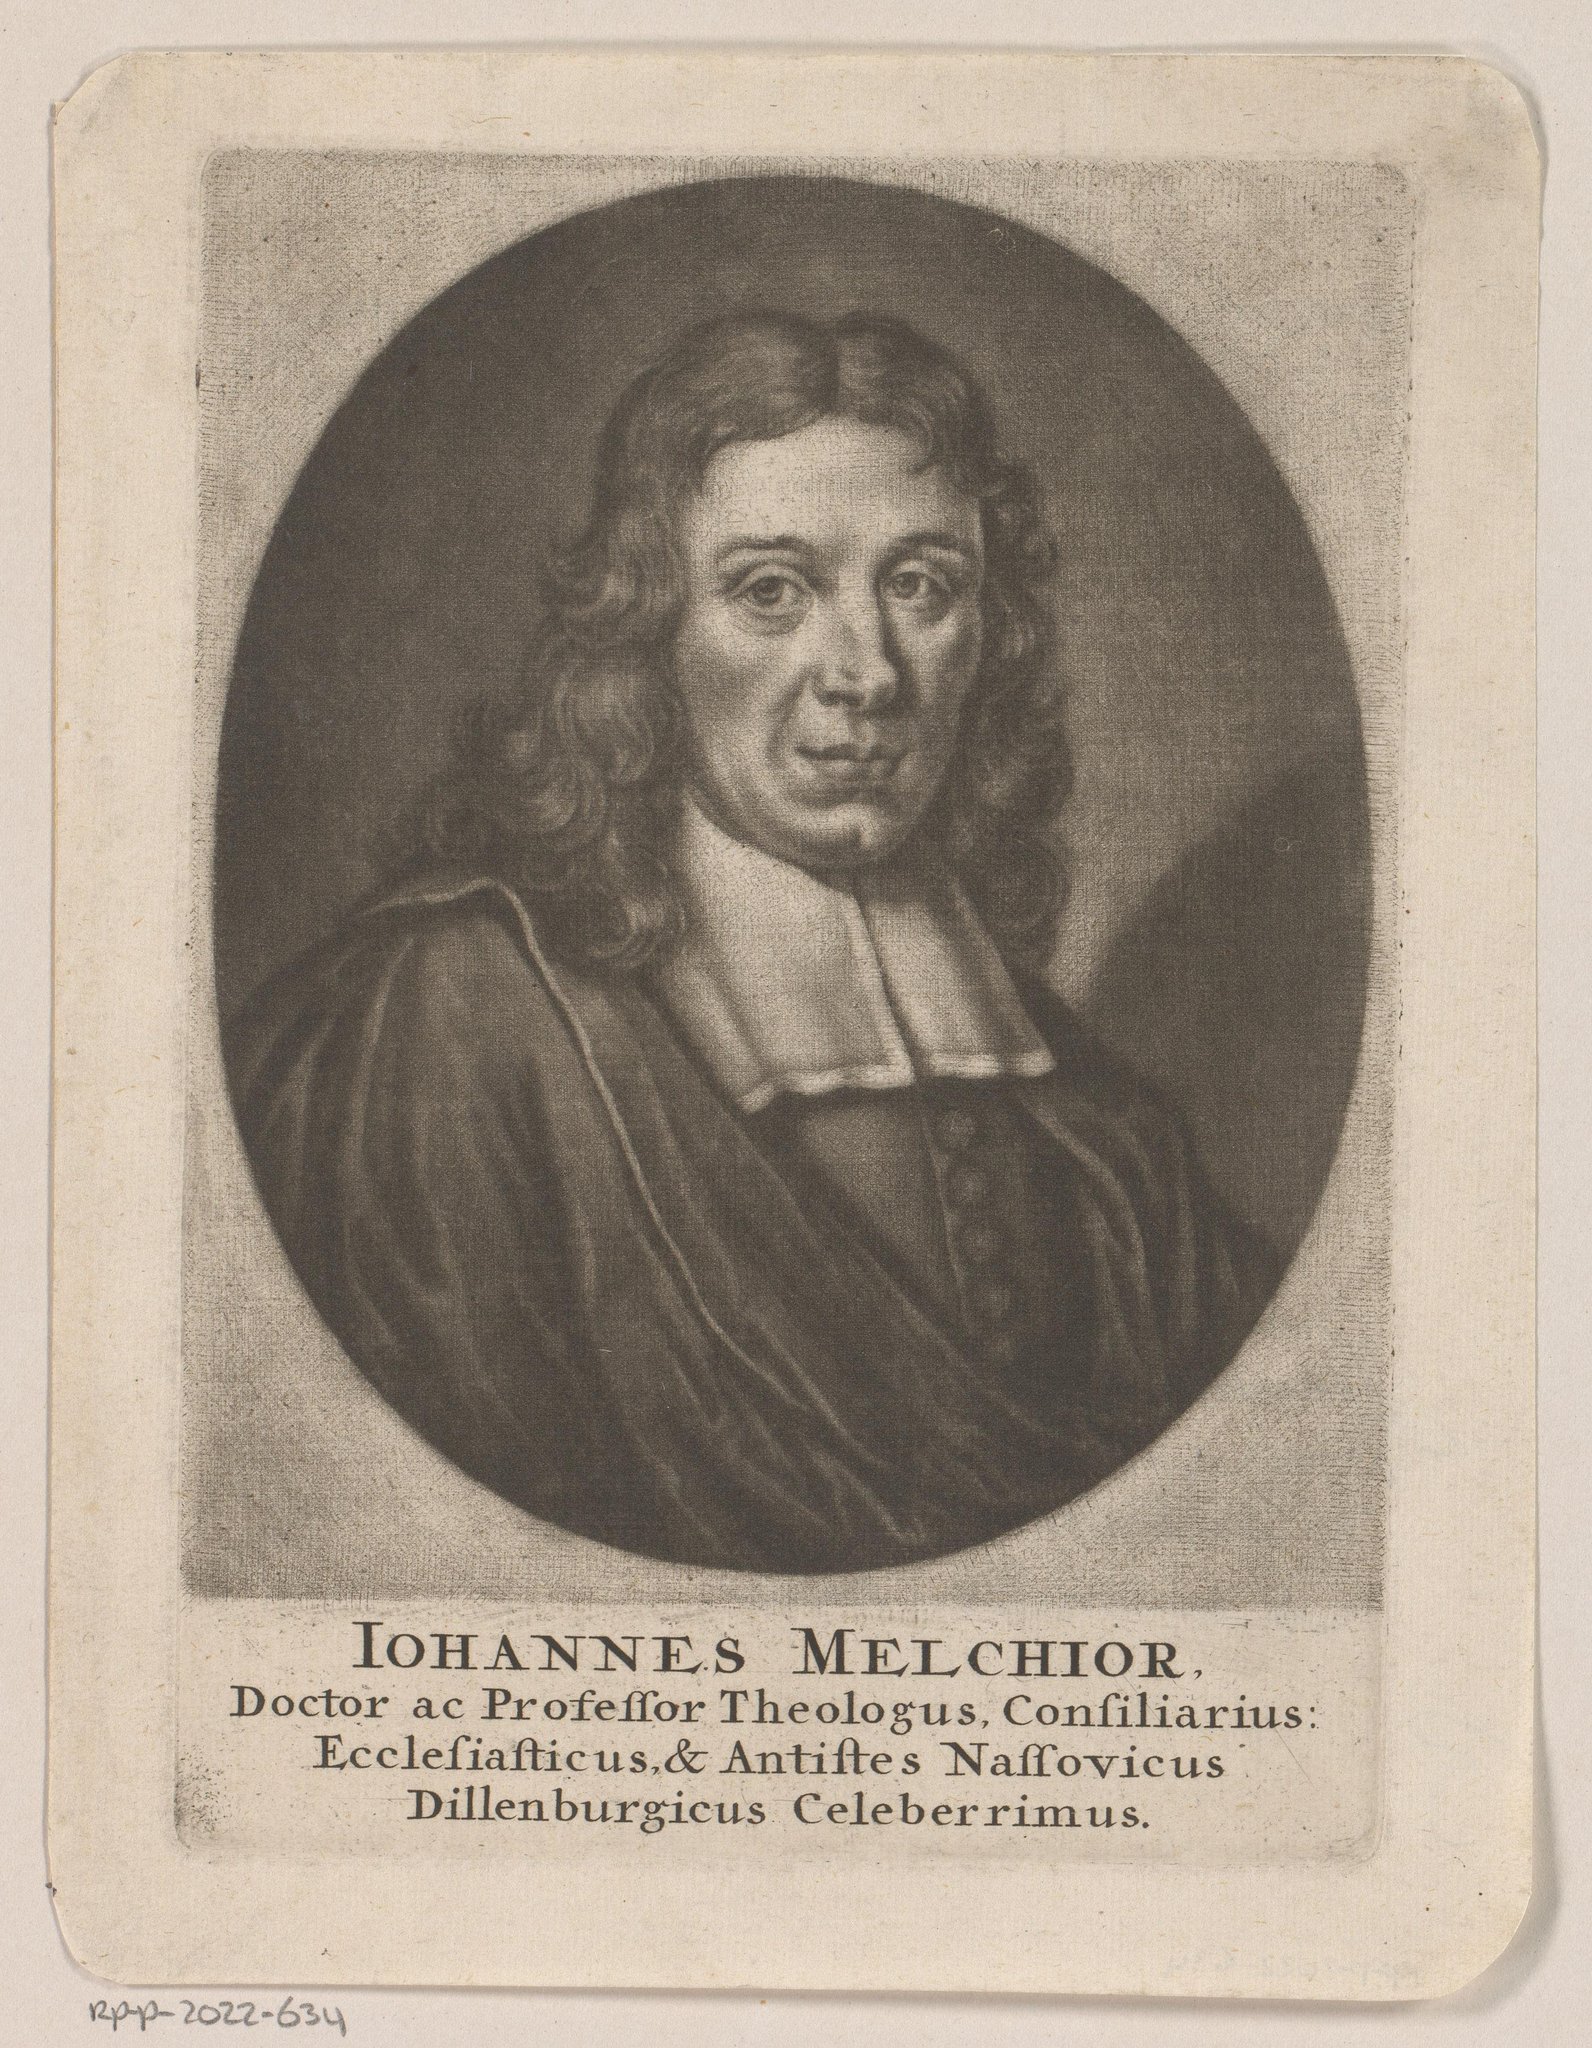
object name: print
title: Iohannes Melchior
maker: Anonymous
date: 1672-1800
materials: paper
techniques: mezzotint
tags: theologian, historical persons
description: Met drieregelig onderschrift in het Latijn.